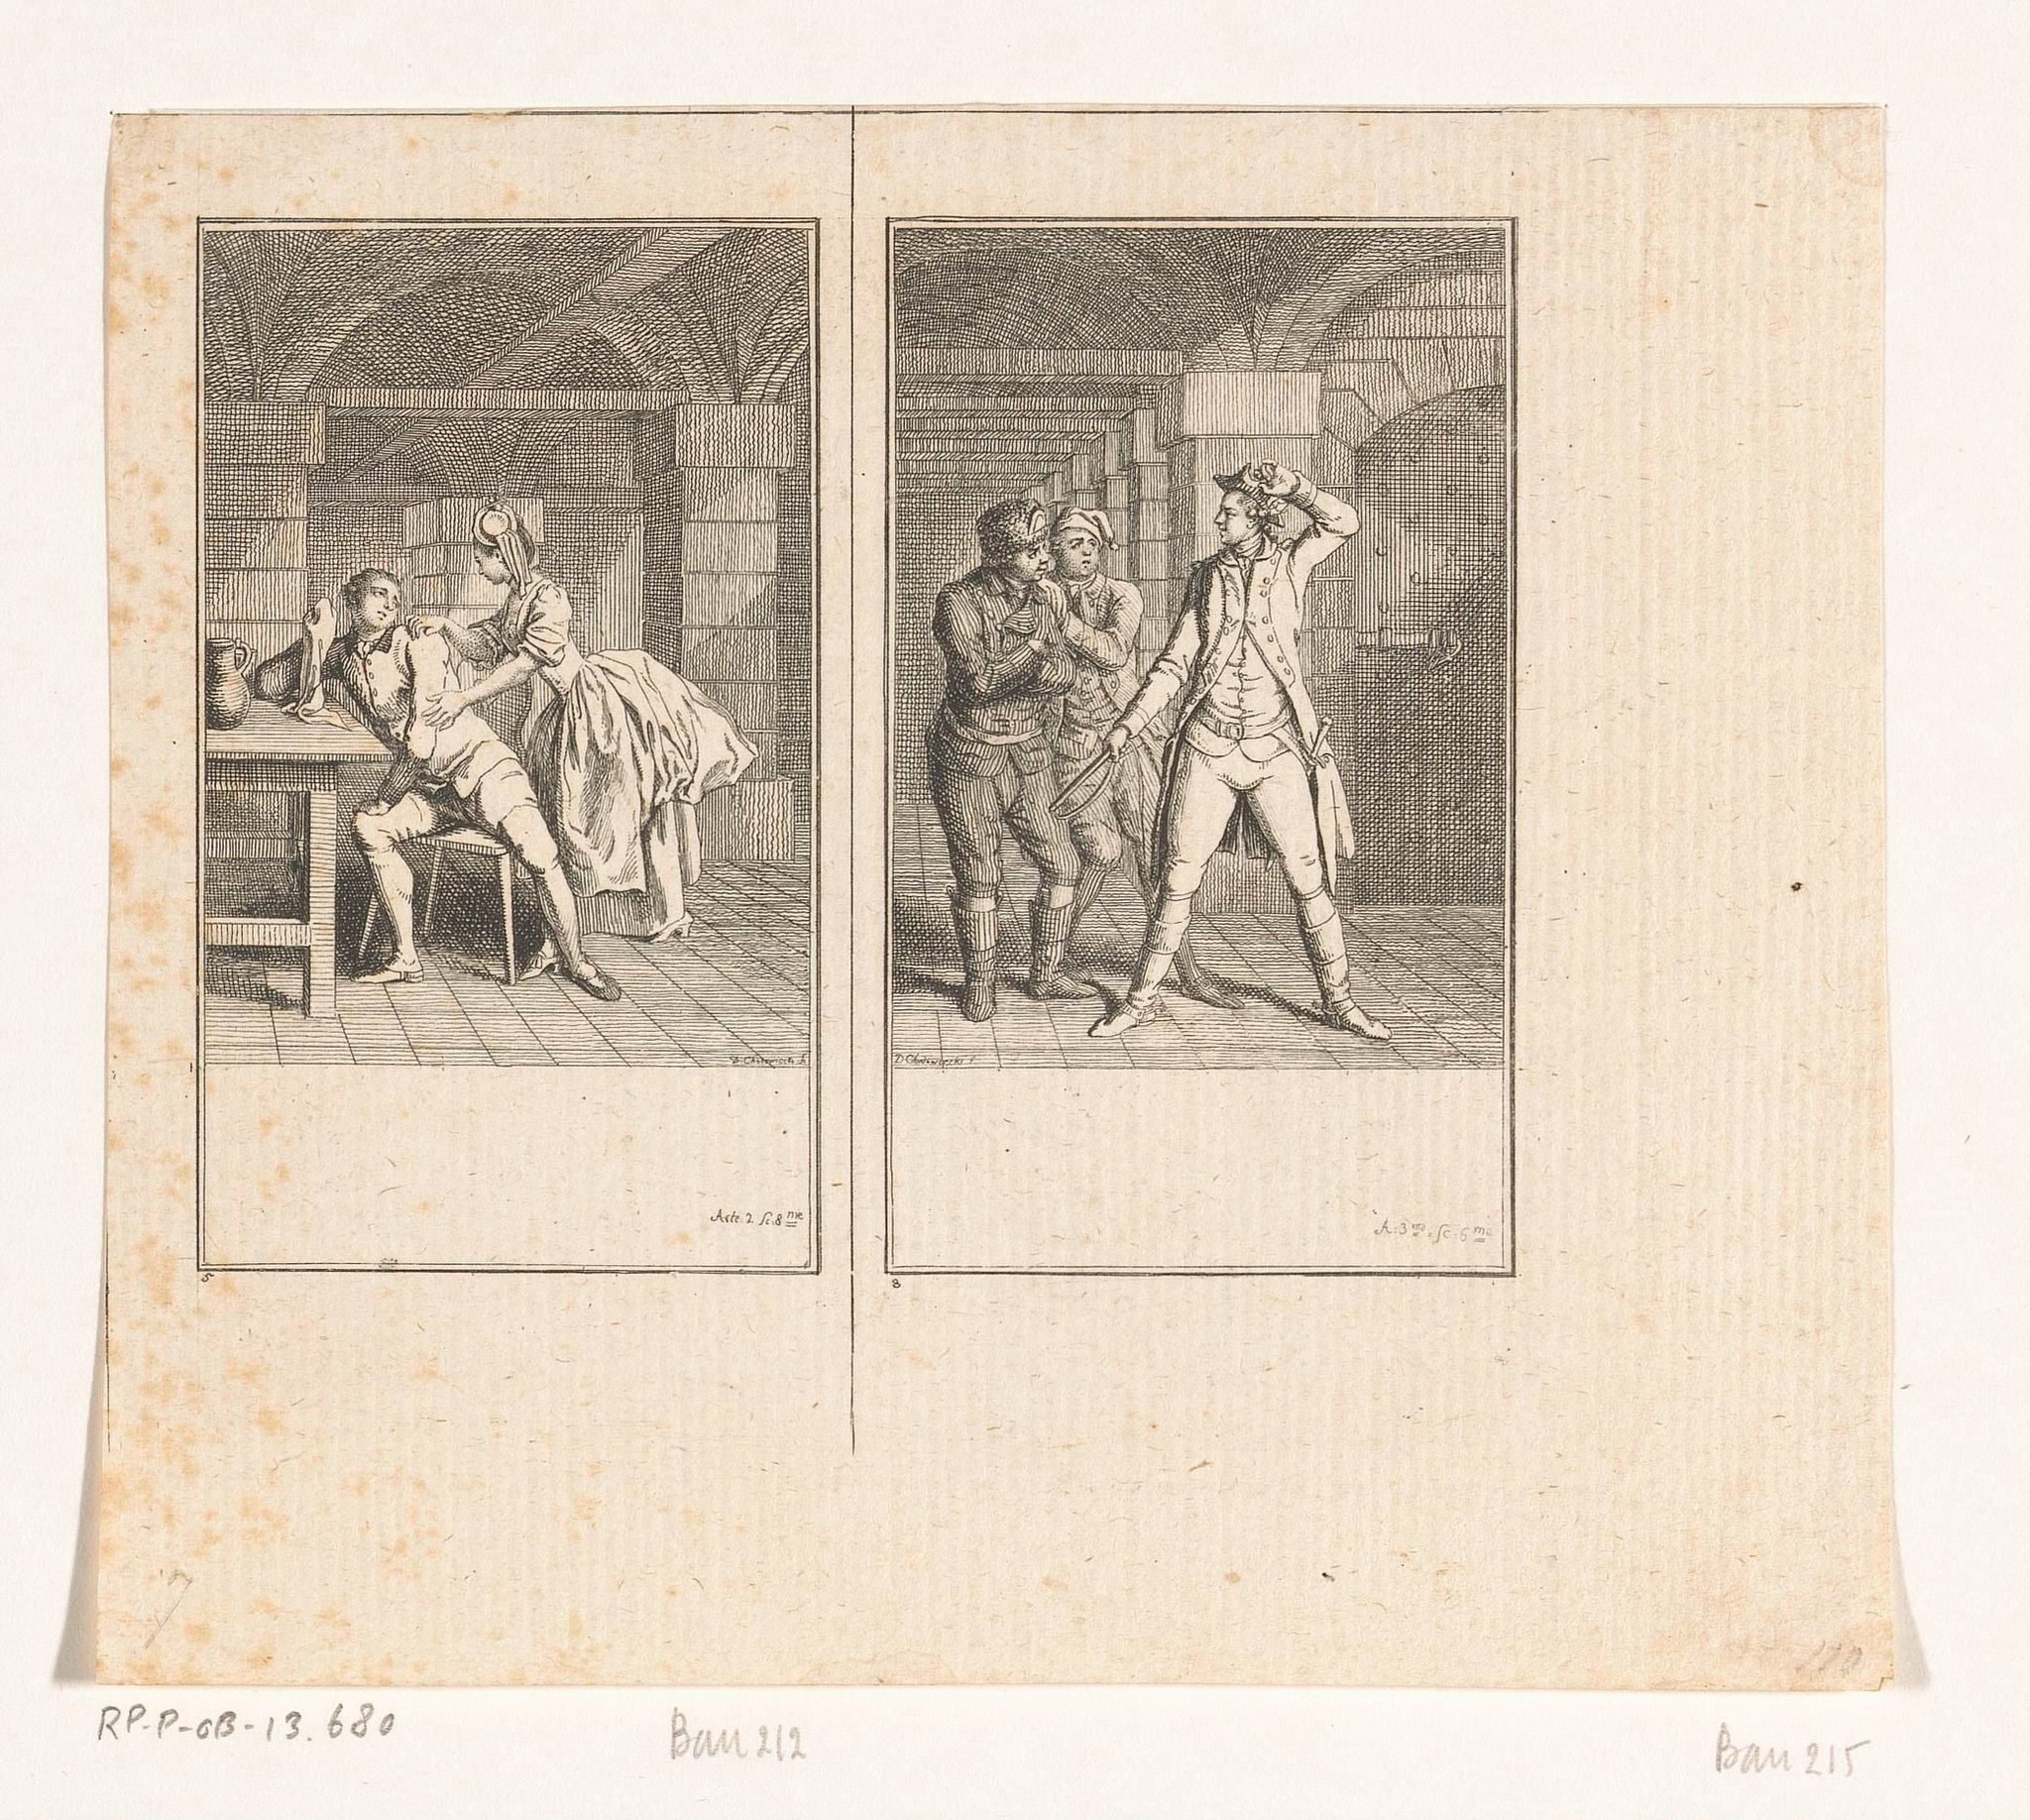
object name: print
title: Twee scènes uit de Deserteur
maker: daniel nikolaus chodowiecki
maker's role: draughtsman, print maker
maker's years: 1726-1801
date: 1774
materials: paper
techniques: etching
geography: berlin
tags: paris, prison, jail, literature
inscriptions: collector's mark: Lugt 2228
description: Vijfde en achtste scène uit een serie van twaalf scènes die de opéra comique 'Le déserteur' door Michel-Jean Sedaine illustreren. De scènes werden op een plaat geëtst. De tweede staat van deze serie werd ook gebruikt in: 'Berliner genealogischen Calender auf das Jahr 1775'.